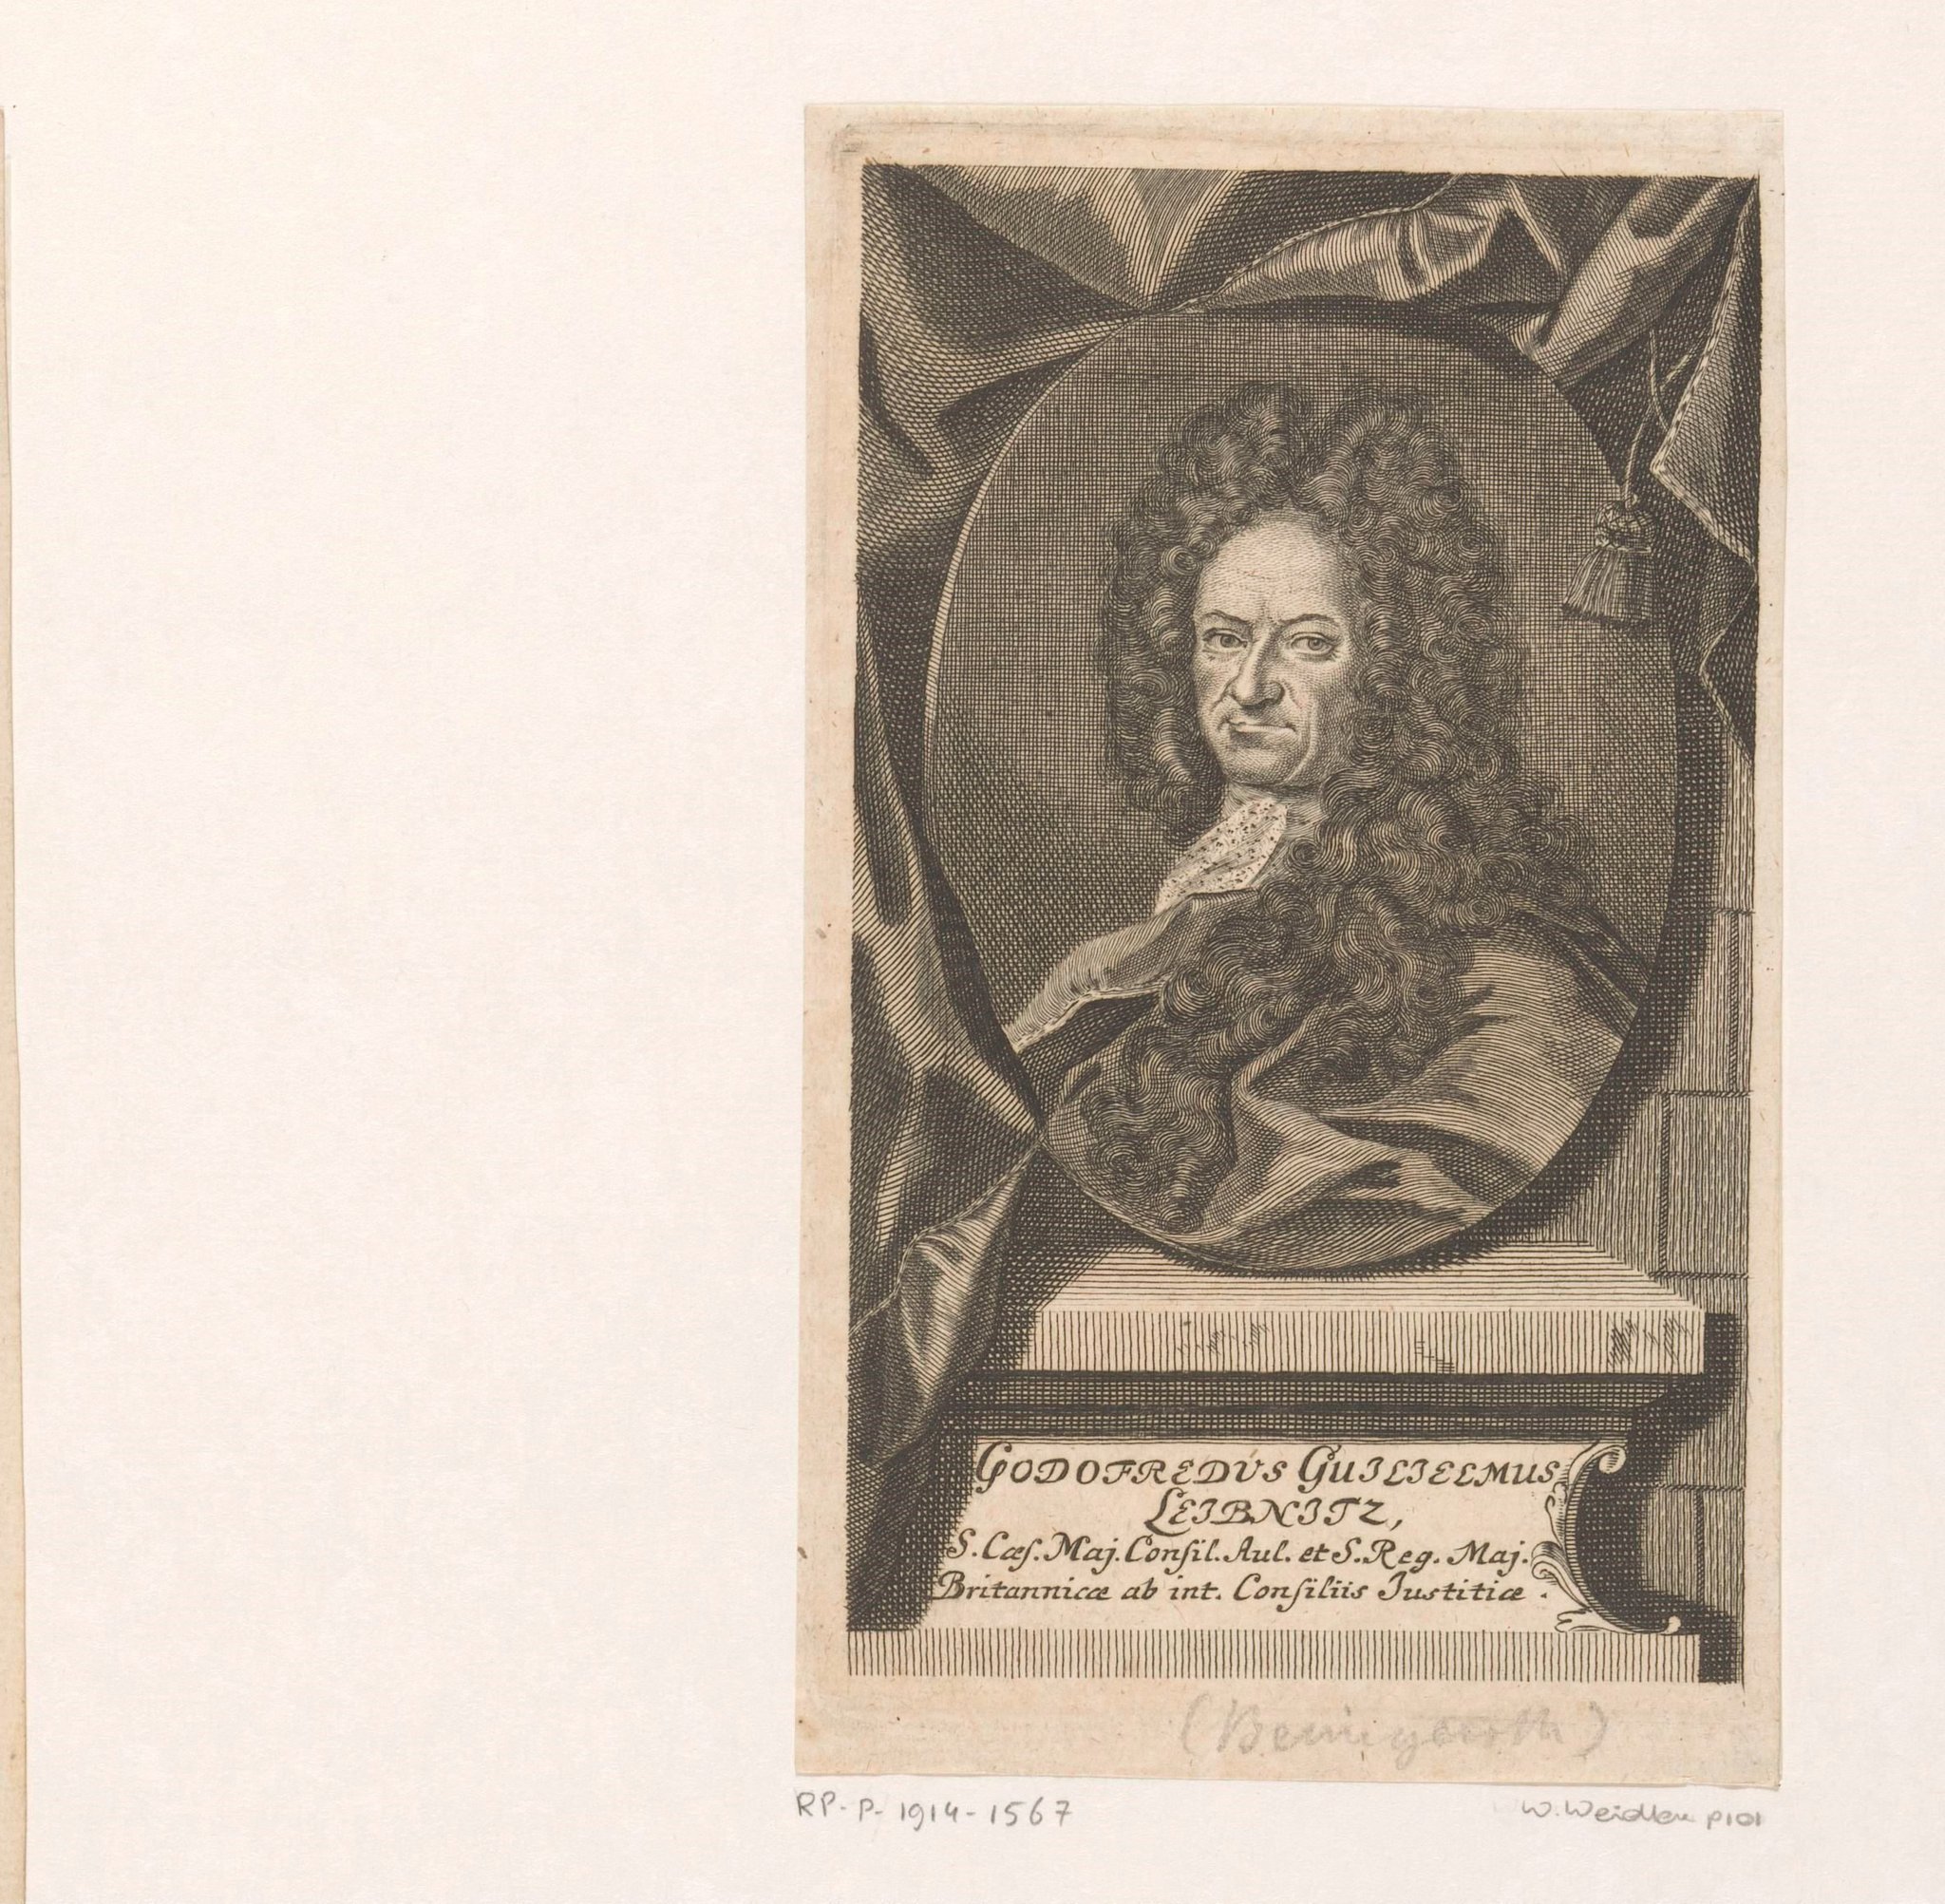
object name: print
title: Portret van Gottfried Wilhelm Leibniz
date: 1717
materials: paper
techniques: engraving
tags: historical persons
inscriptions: collector's mark: Lugt 2228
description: Prent ook gebruikt in: Deutsche Acta Eruditorum (...). dl. 51. Leipzig: Johann Gottlieb Gleditsch, 1717.